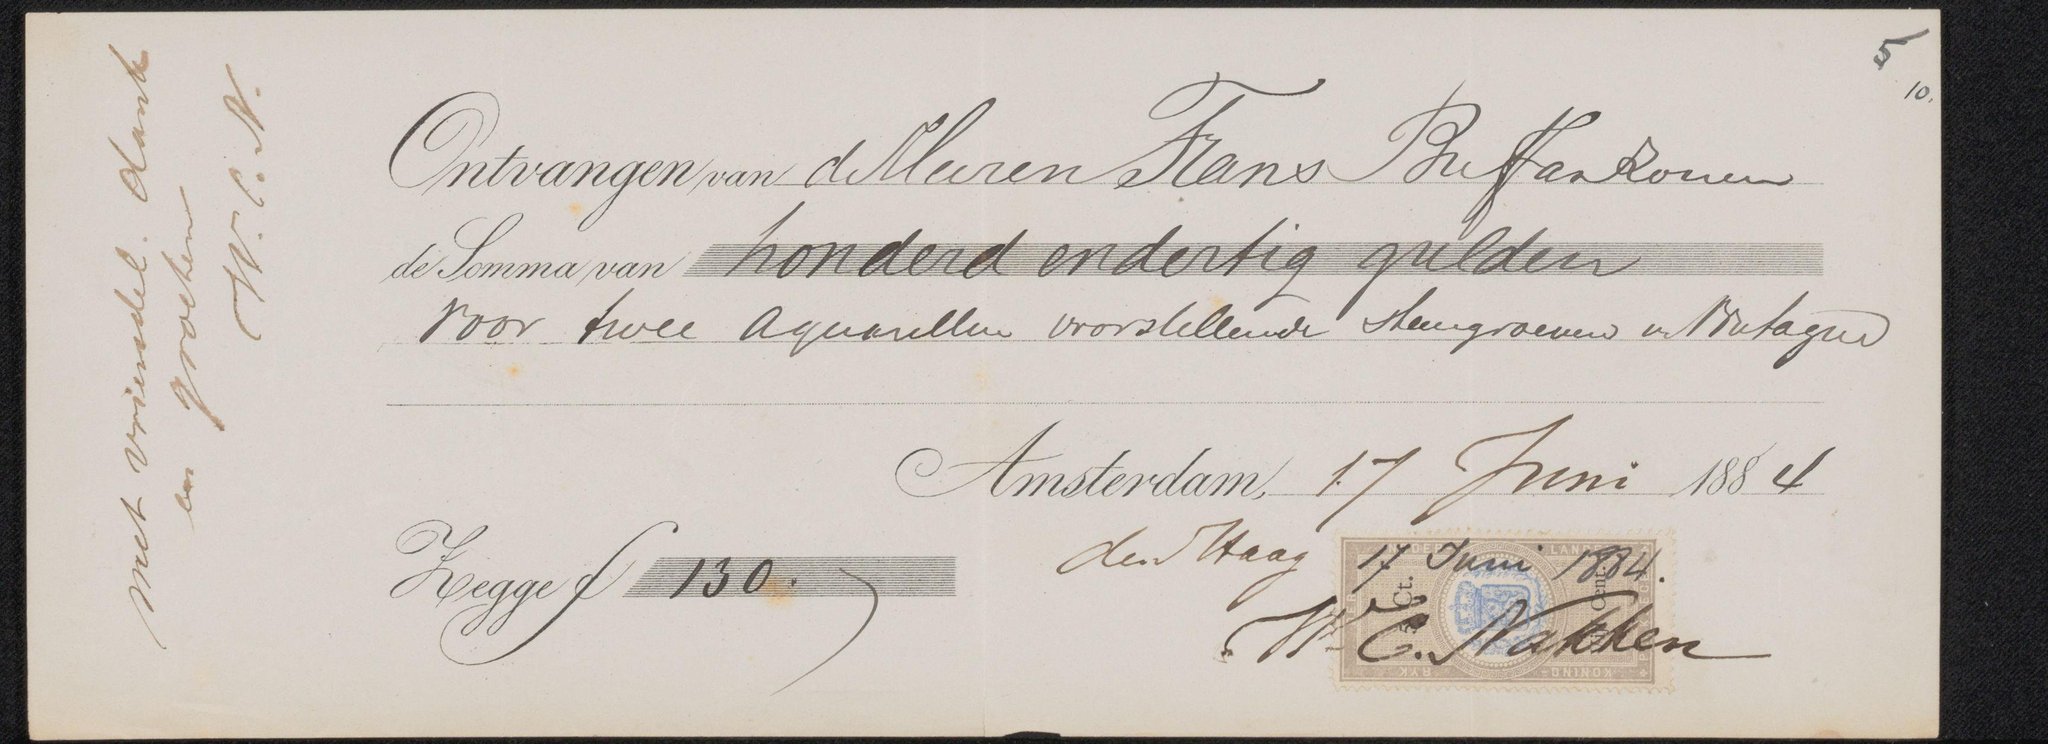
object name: ontvangstbewijs, kwitantie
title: Kwitantie voor Willem Carel Nakken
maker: willem carel nakken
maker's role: draughtsman, painter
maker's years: 1835-1926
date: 1884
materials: ink, paper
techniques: pen, printing, writing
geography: amsterdam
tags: drawing, money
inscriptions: collector's mark: Lugt 2233